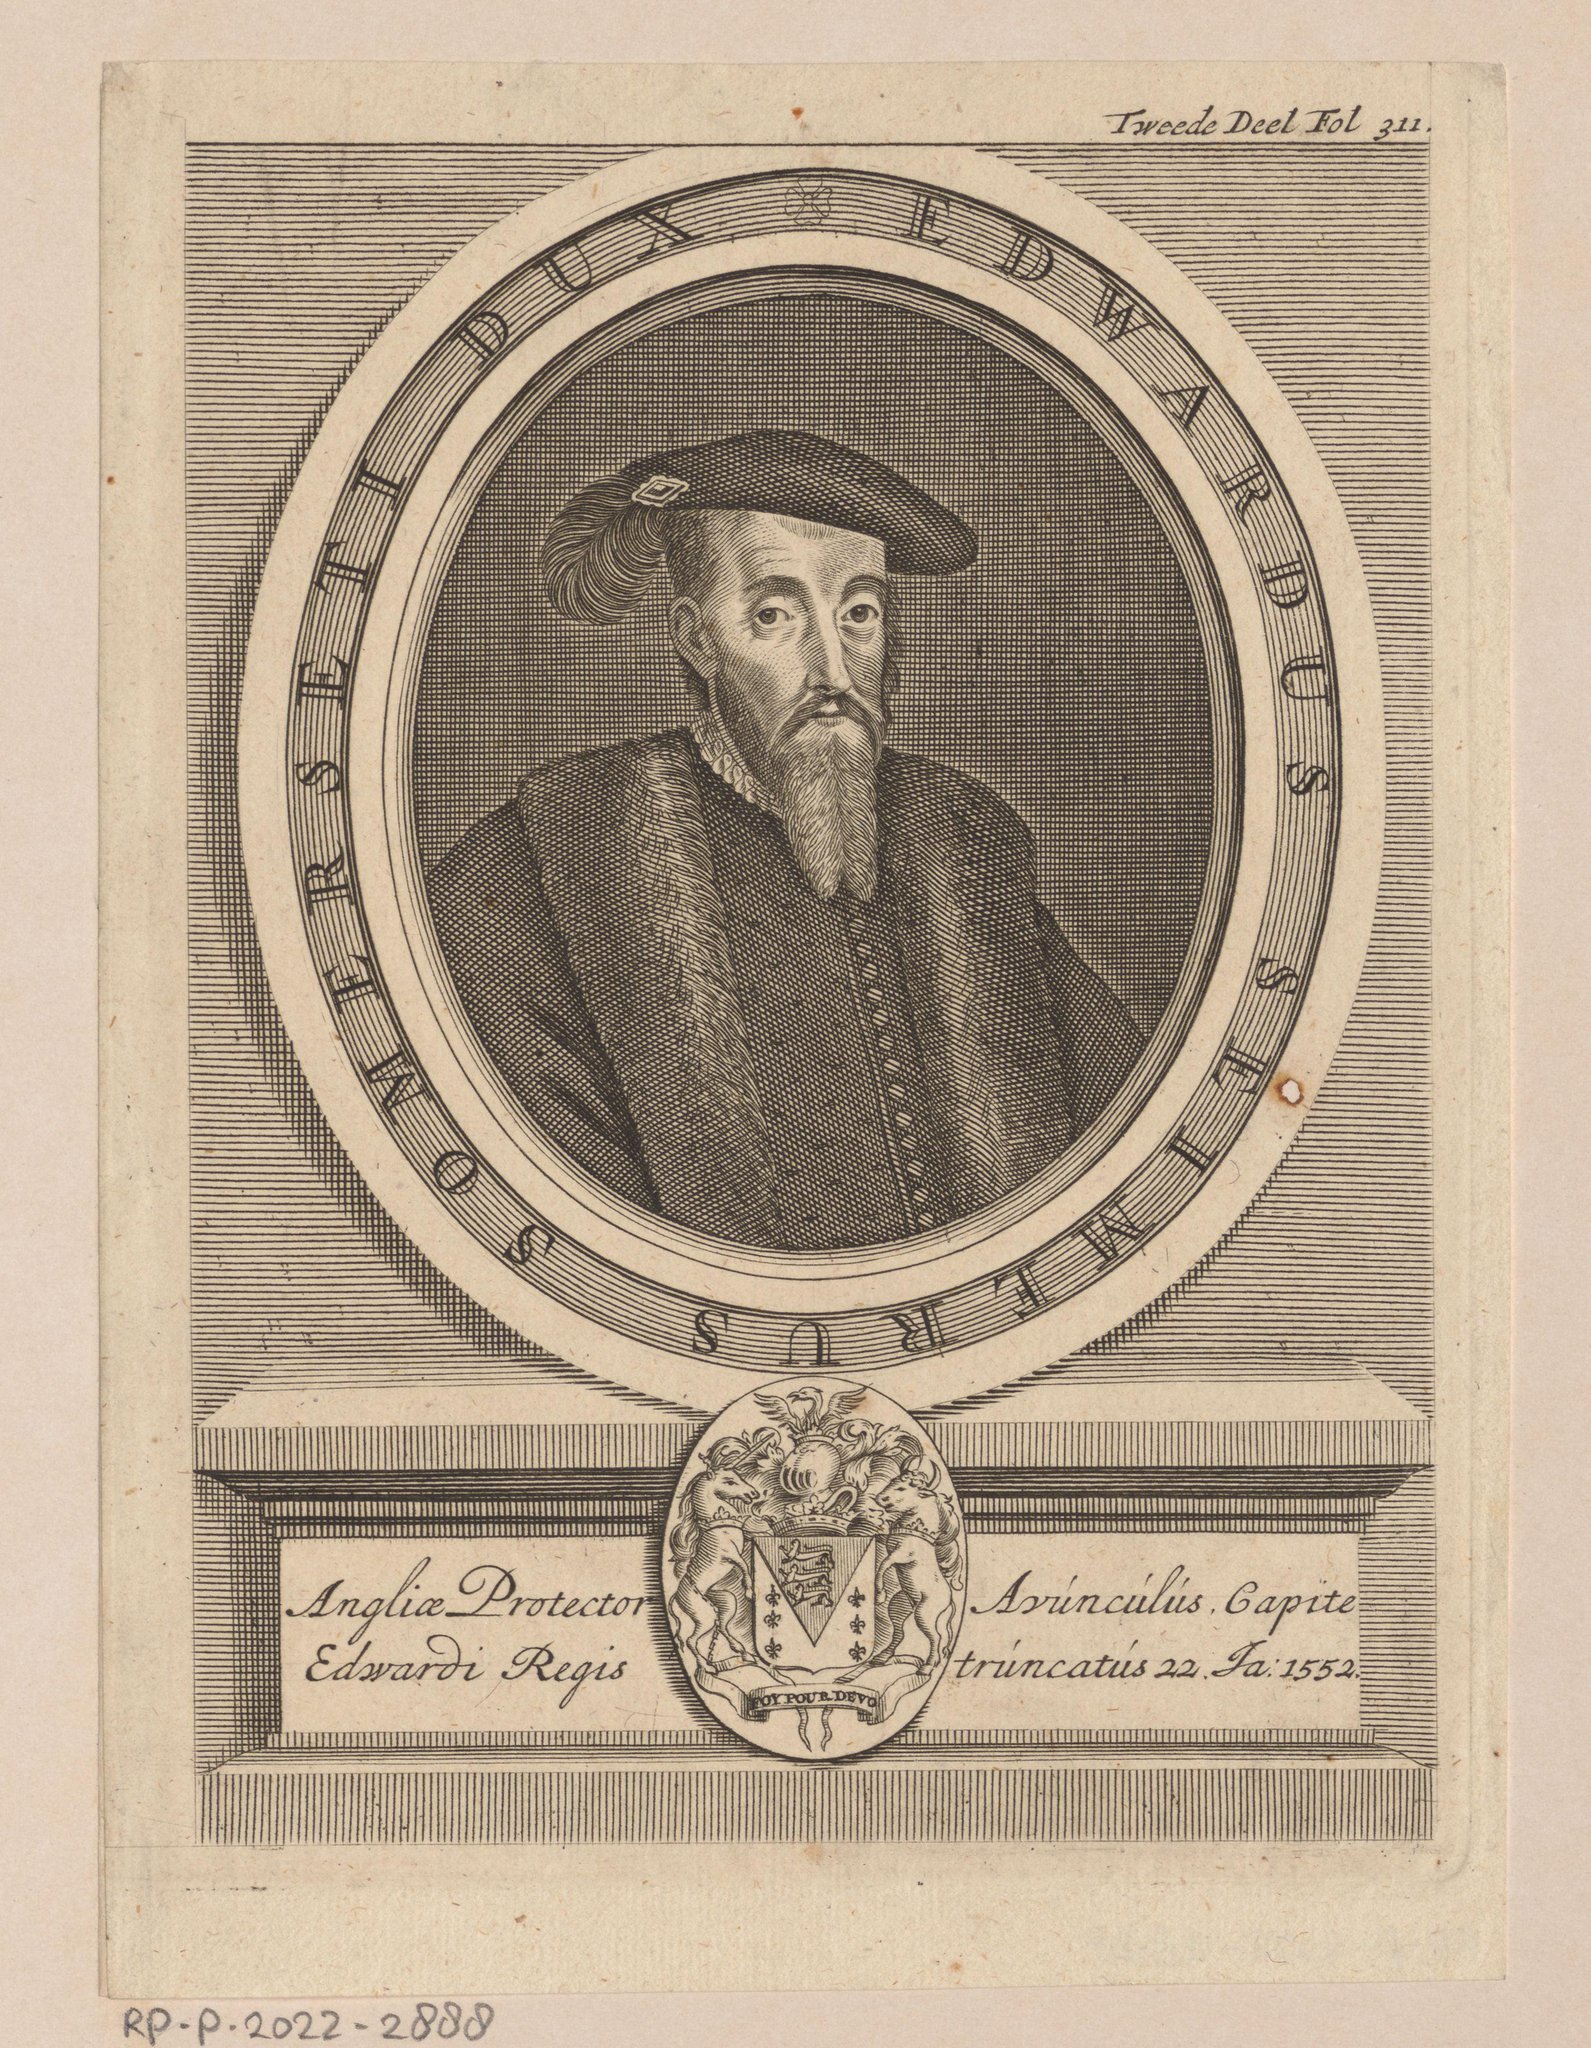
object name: print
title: Portret van Edward Seymour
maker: Anonymous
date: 1600-1750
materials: paper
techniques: engraving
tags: historical persons, armorial bearing, heraldry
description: Met tweeregelig onderschrift in twee kolommen in het Latijn. Rechtsboven: Tweede Deel Fol 311.